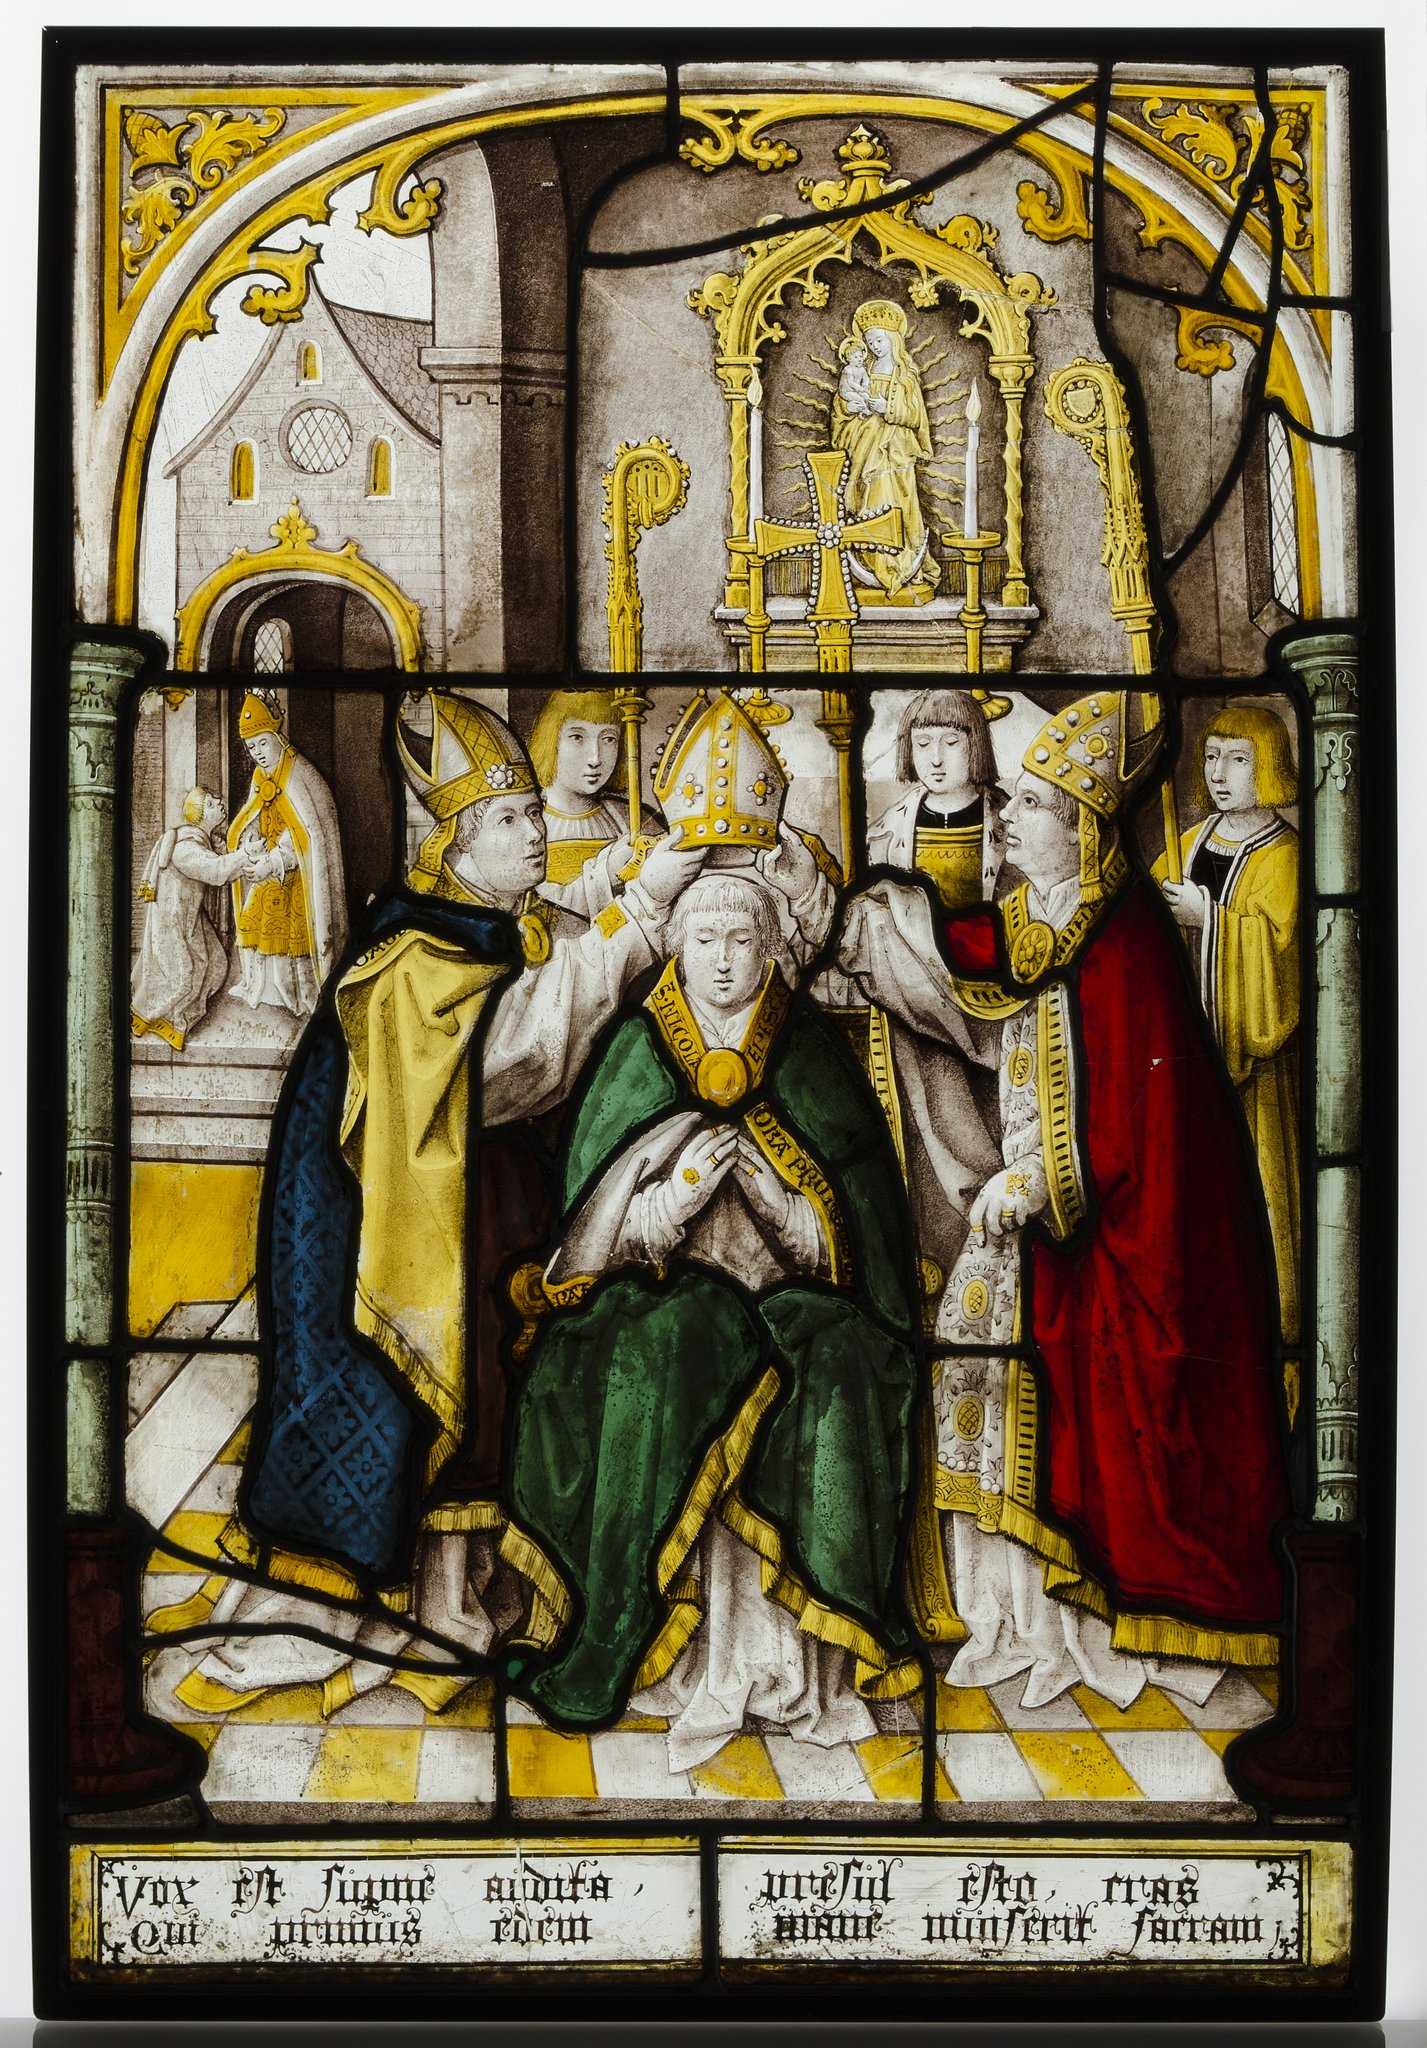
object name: panel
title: Glass Panel of Saint Nicholas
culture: dutch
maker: jacob cornelisz van oostsanen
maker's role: artist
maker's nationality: netherlandish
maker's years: 1465-1533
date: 1501-1600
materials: glass, metal, paint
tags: men,madonna and child,cross,croziers,saints